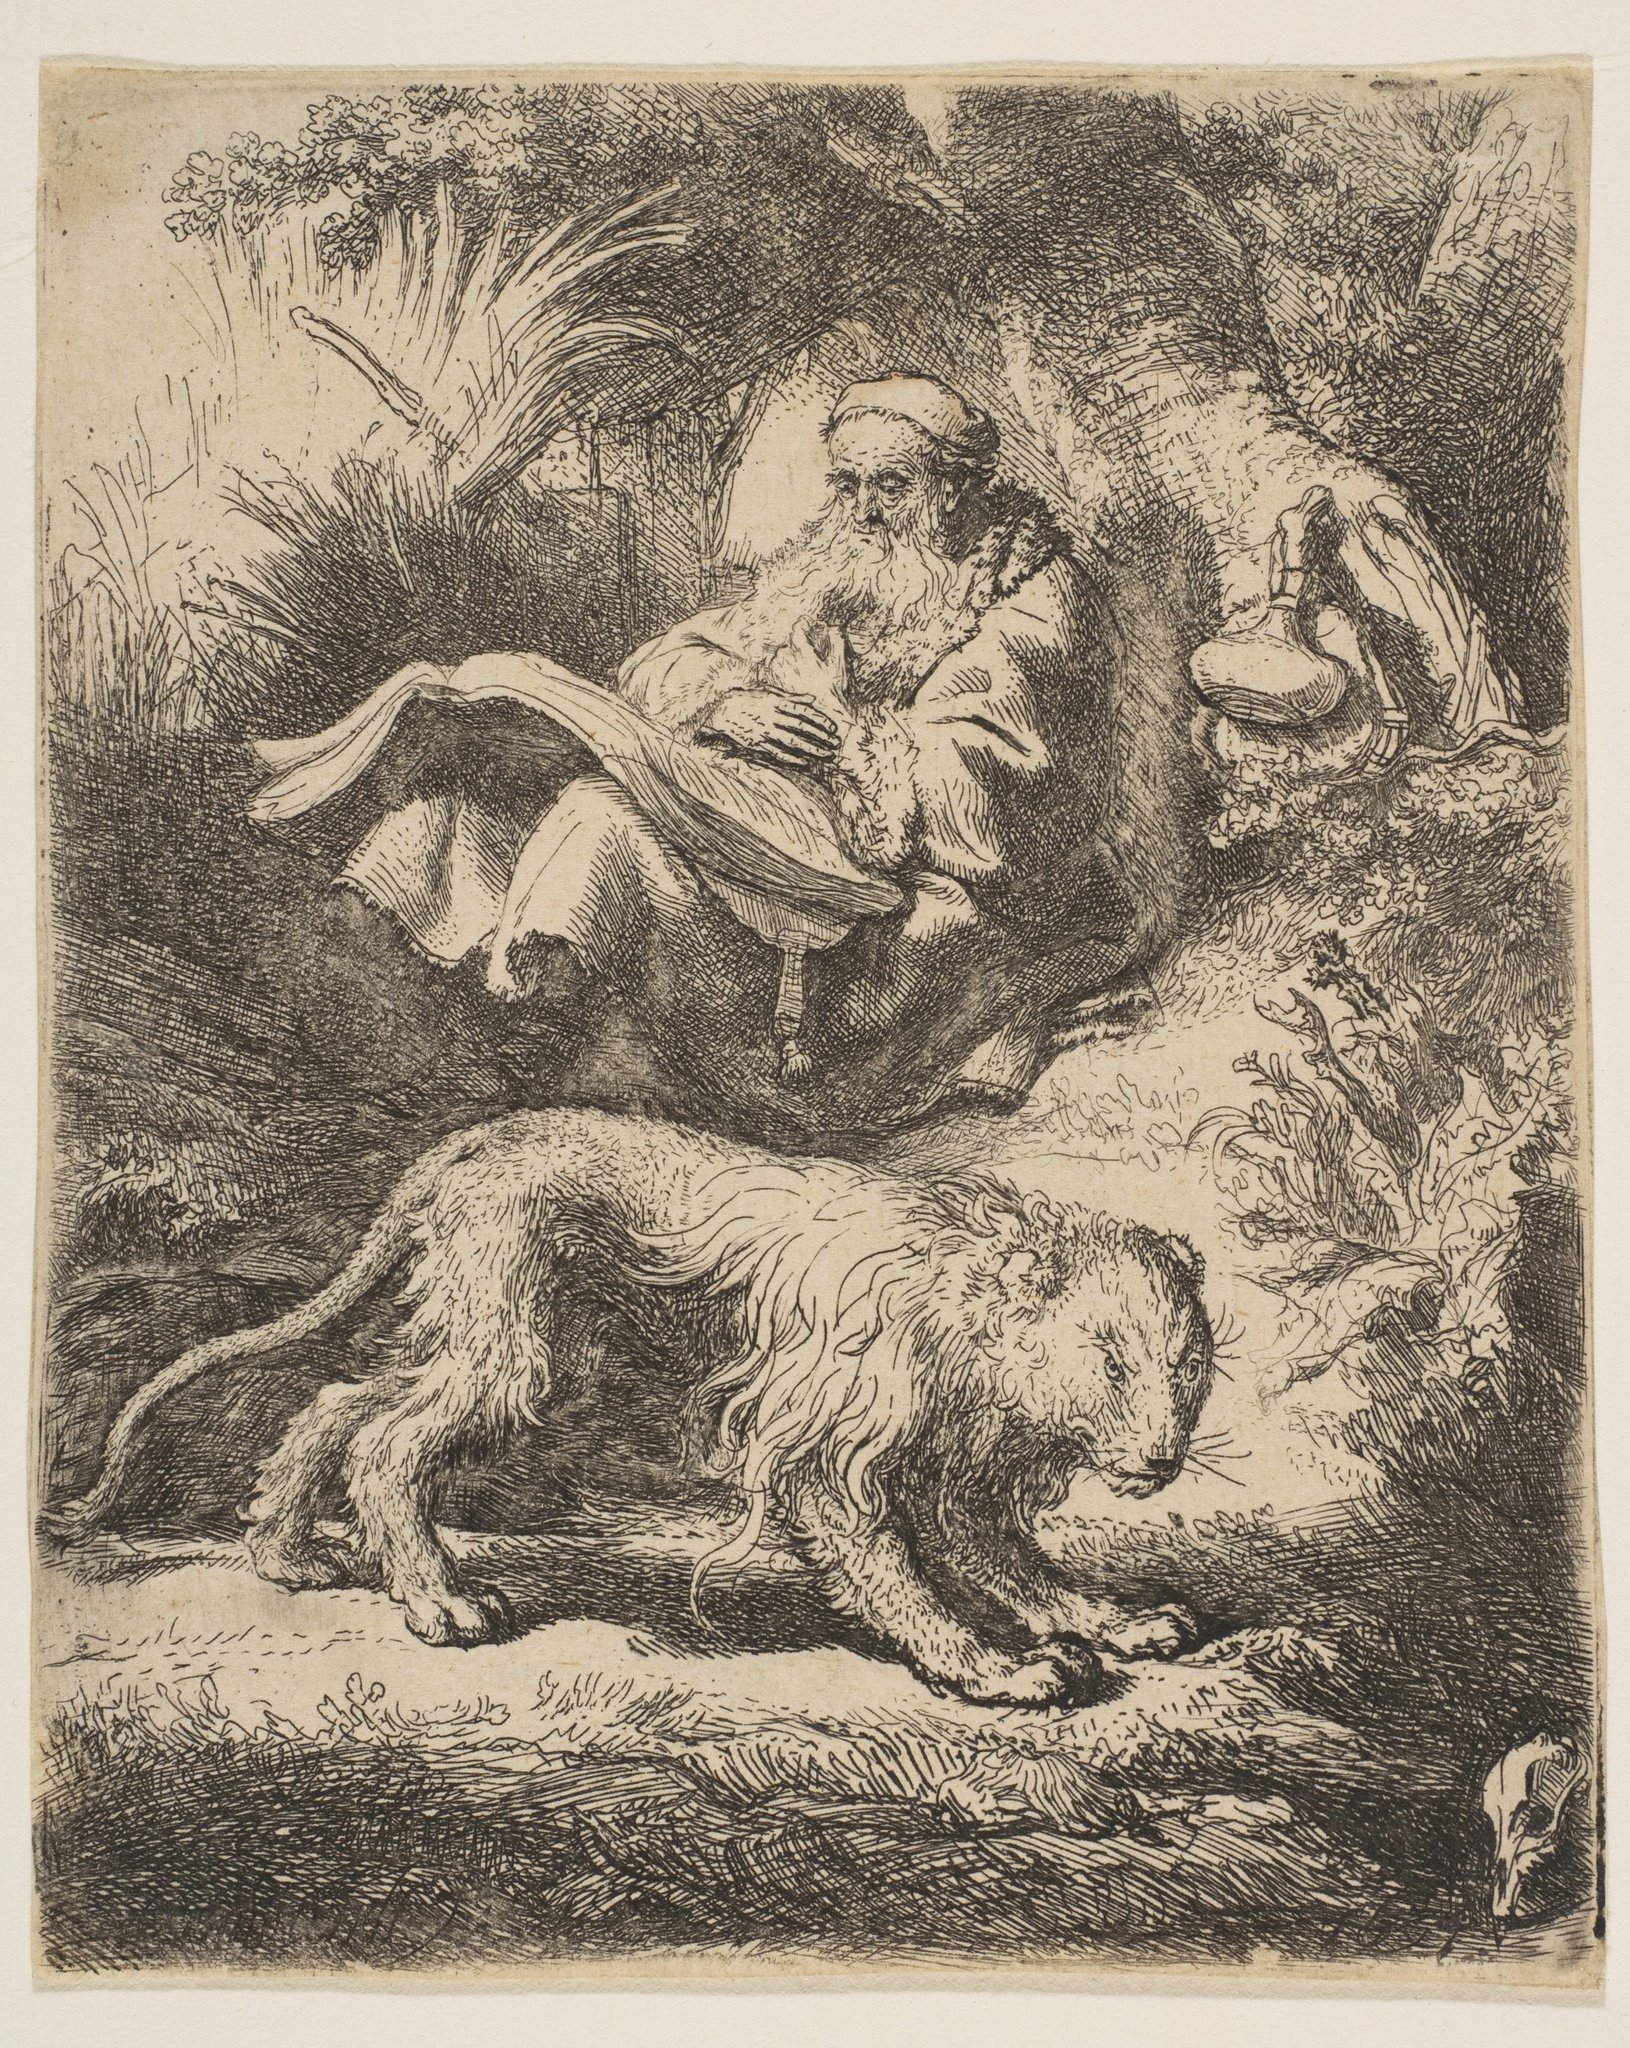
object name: print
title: St. Jerome Reading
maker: rembrandt van rijn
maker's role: artist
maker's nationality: dutch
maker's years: 1606-1669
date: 1634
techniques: etching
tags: reading,lions,trees,saint jerome